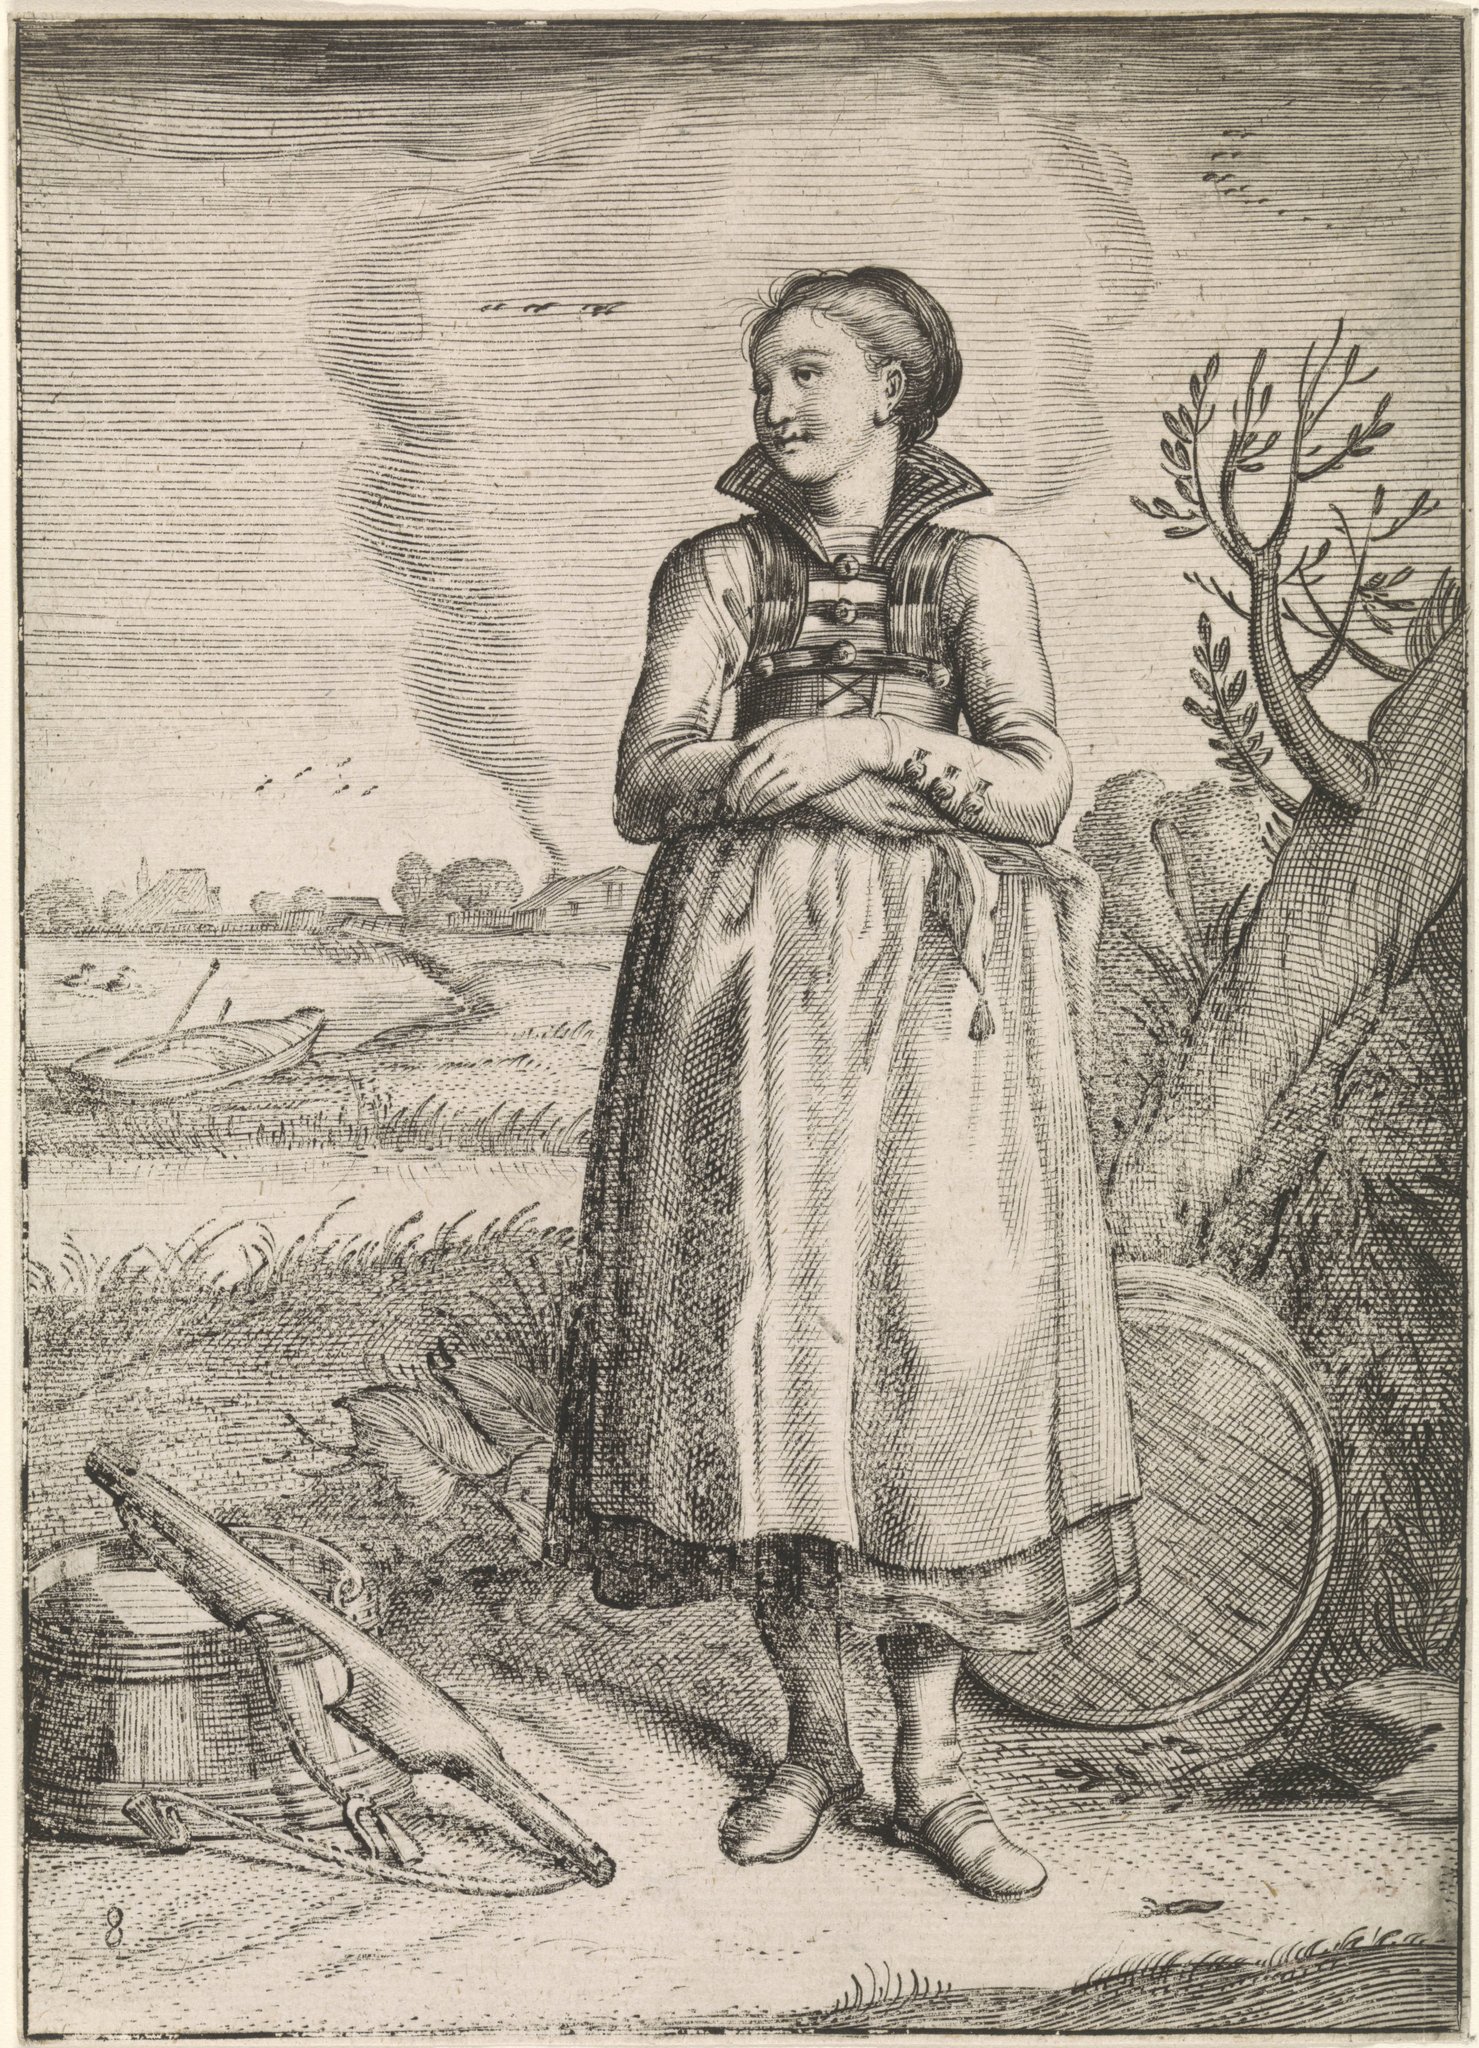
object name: costume print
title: Habitus et cultus Matronarum Nobilu et Rusticarum apud Batauos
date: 1619-1623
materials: paper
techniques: engraving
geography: haarlem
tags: folk costume, regional costume, yoke, europeans (with name)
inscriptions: collector's mark: Lugt 240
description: Boeren meisje uit Edam. Naast haar een juk met houten tobbe.